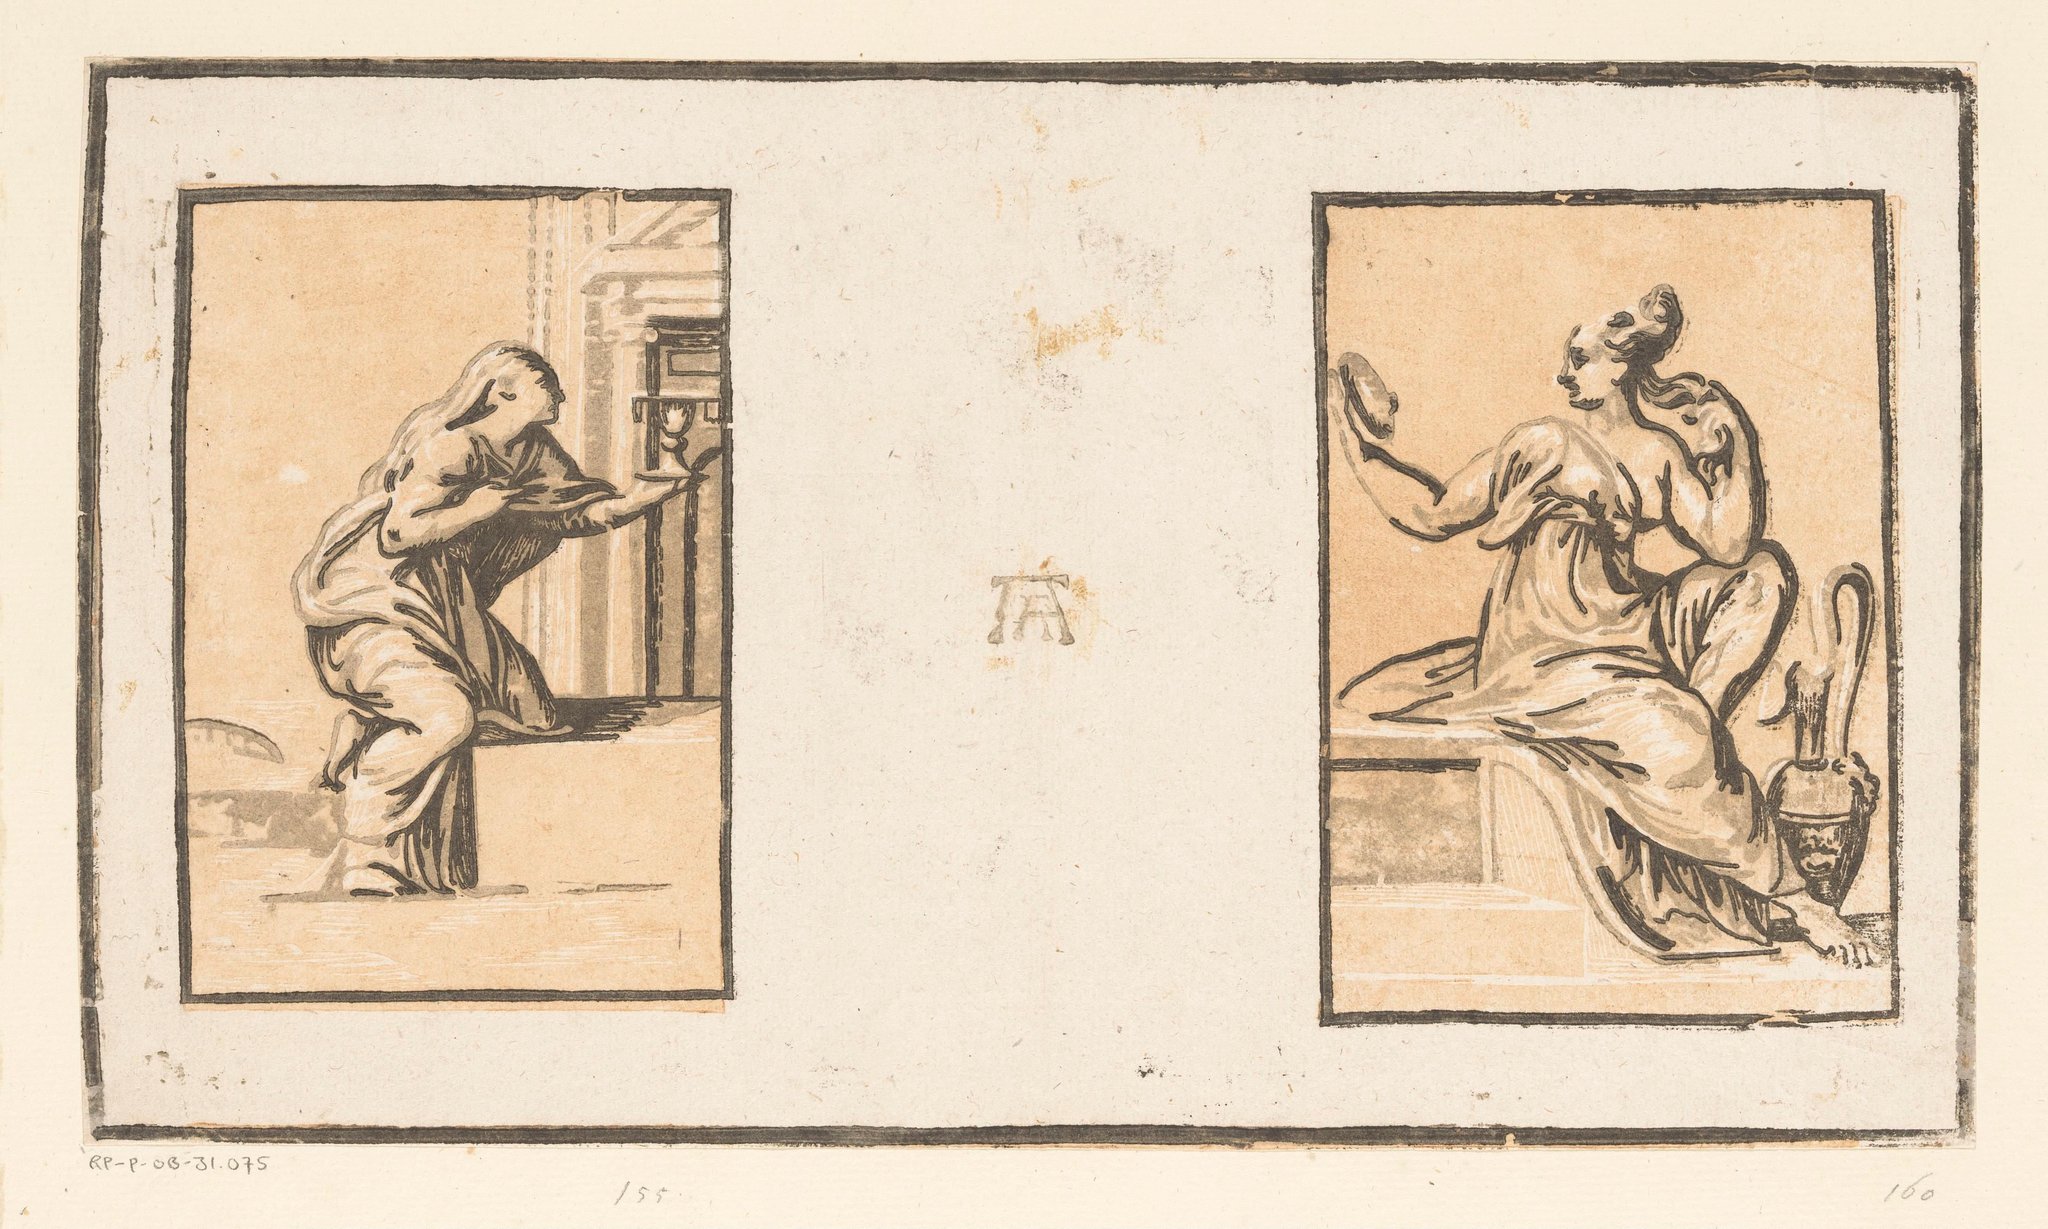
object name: print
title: Geloof en Voorzichtigheid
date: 1502-1532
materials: paper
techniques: woodcut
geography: italy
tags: fides (faith) as roman personification, prudentia (prudence) as roman personification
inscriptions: collector's mark: Lugt 240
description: Links: een vrouwelijke personificatie van het geloof (Fides), knielend met een miskelk in de hand. Rechts: een vrouwelijke personificatie van de voorzichtigheid (Prudentia) met een ronde spiegel in de hand.